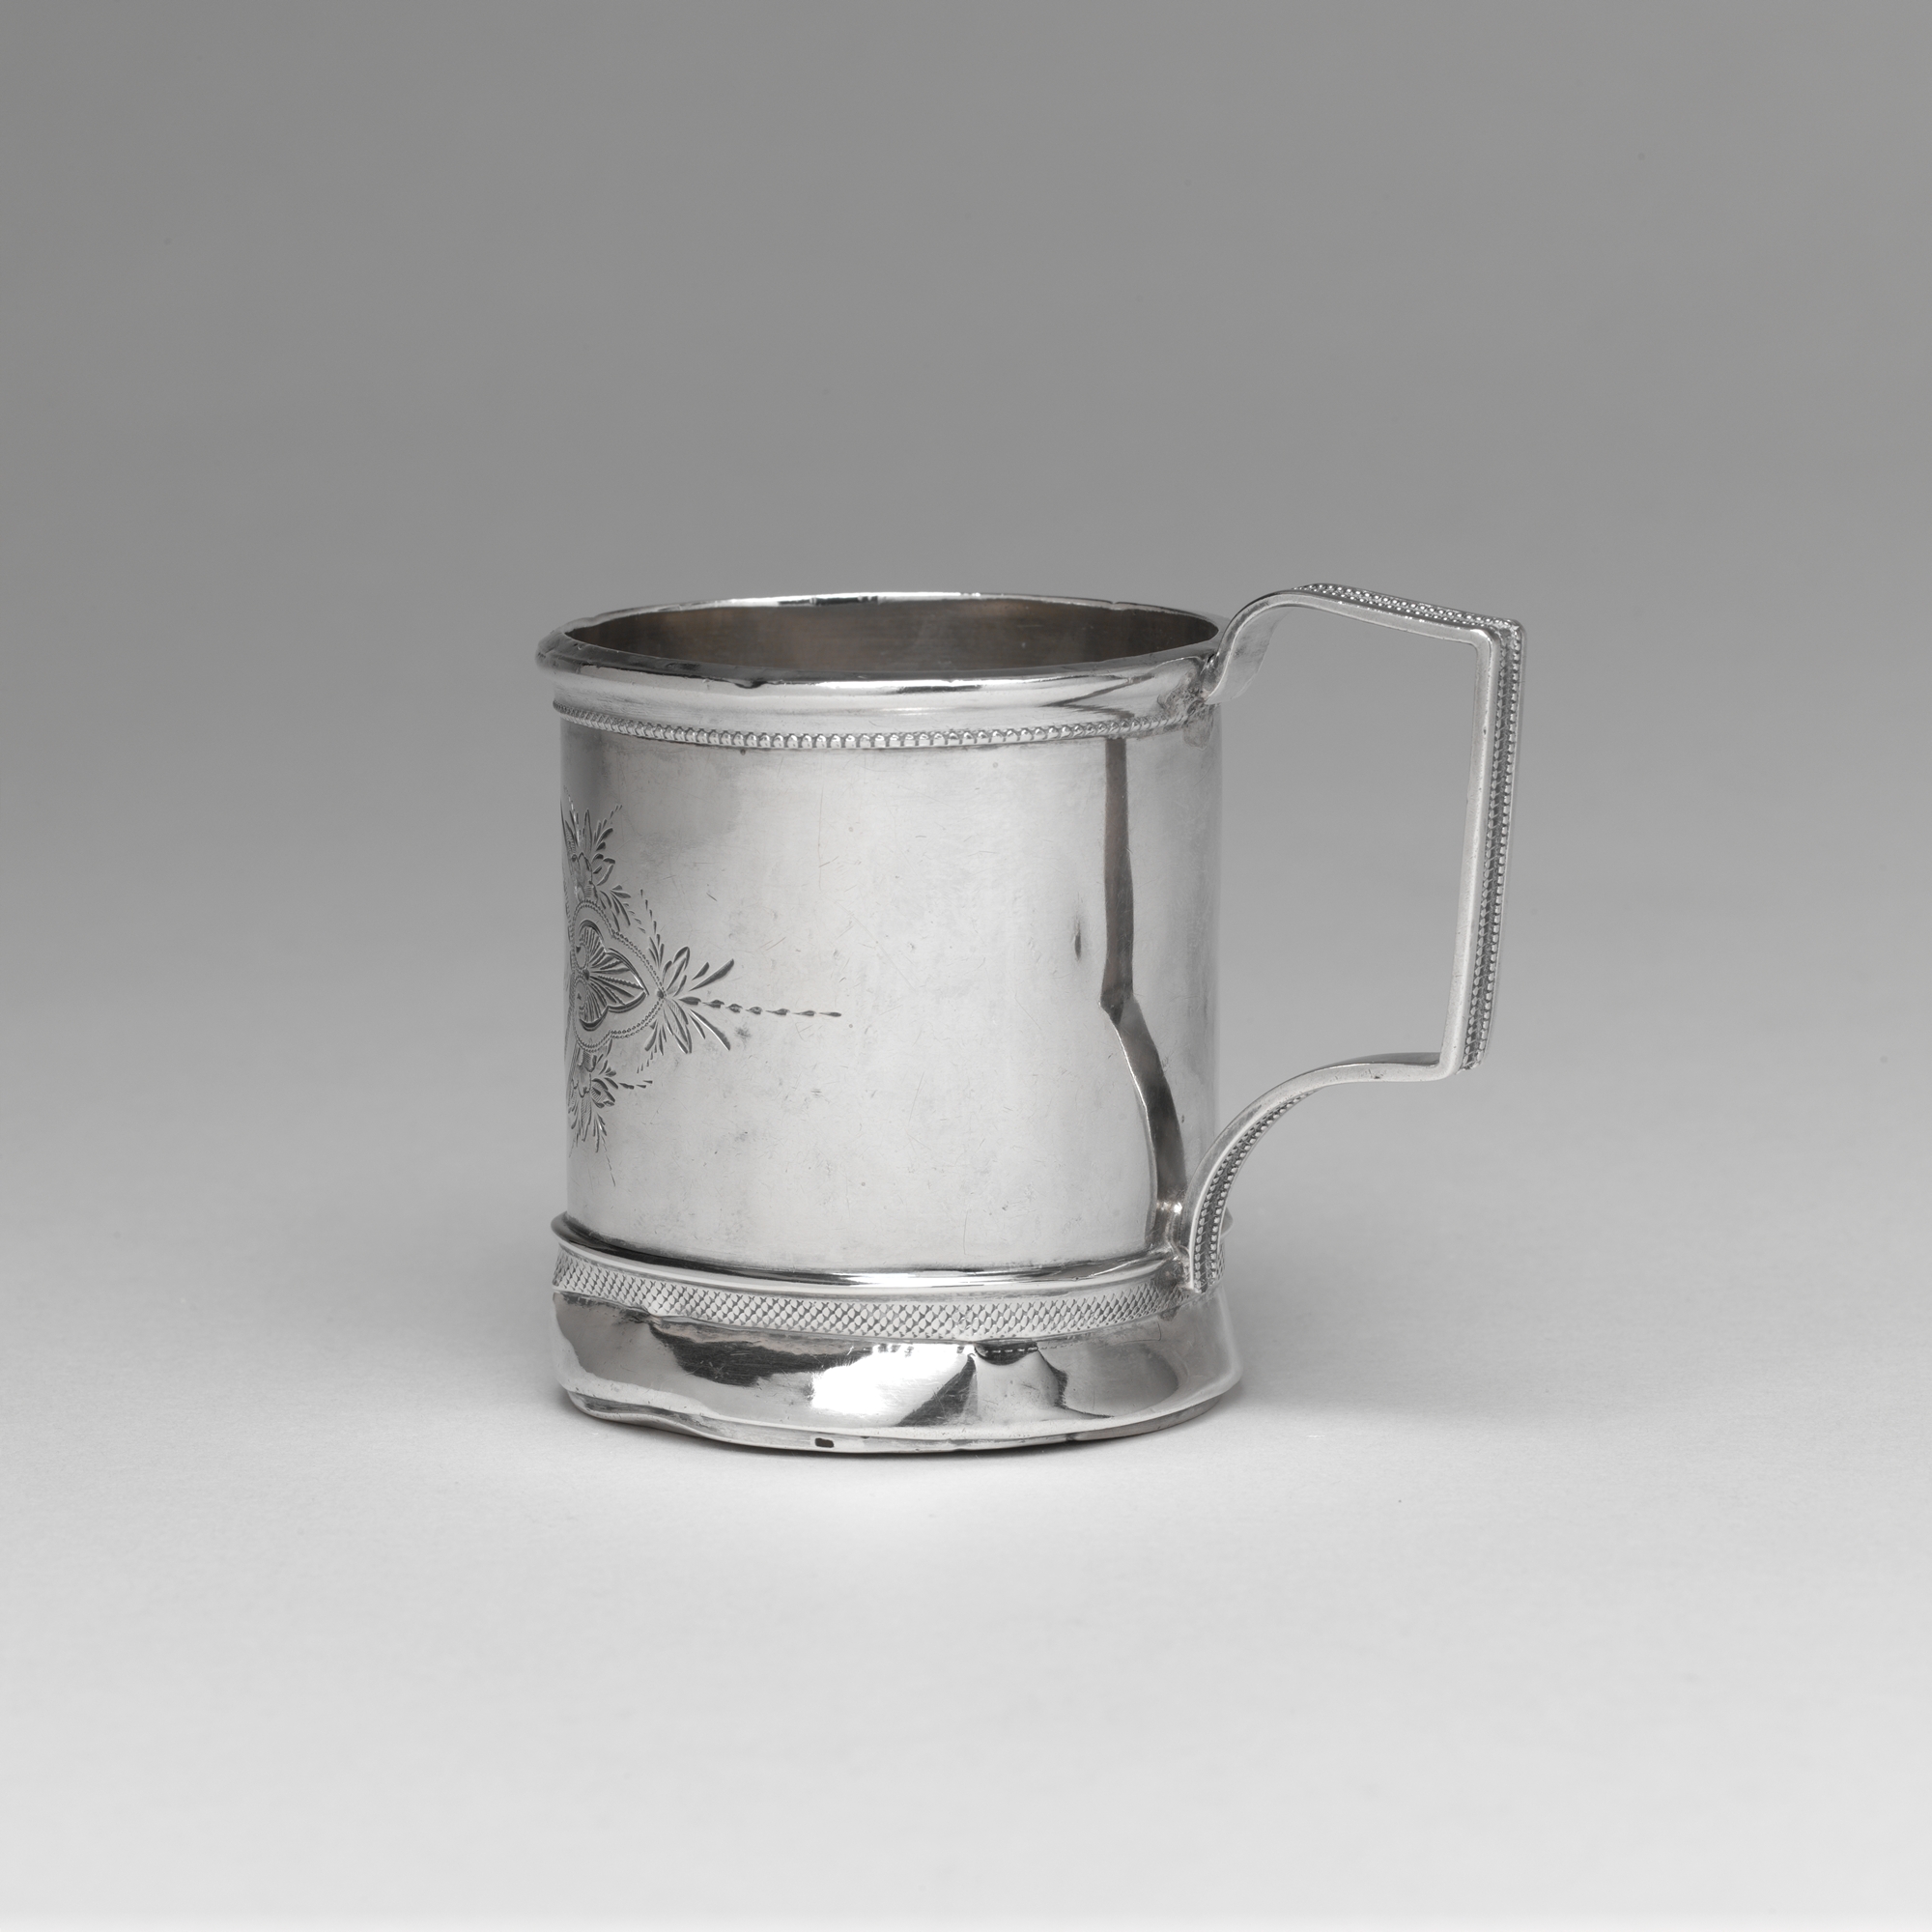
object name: cup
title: Child's Cup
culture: american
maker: albert coles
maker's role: maker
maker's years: 1810-1885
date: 1860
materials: silver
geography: united states